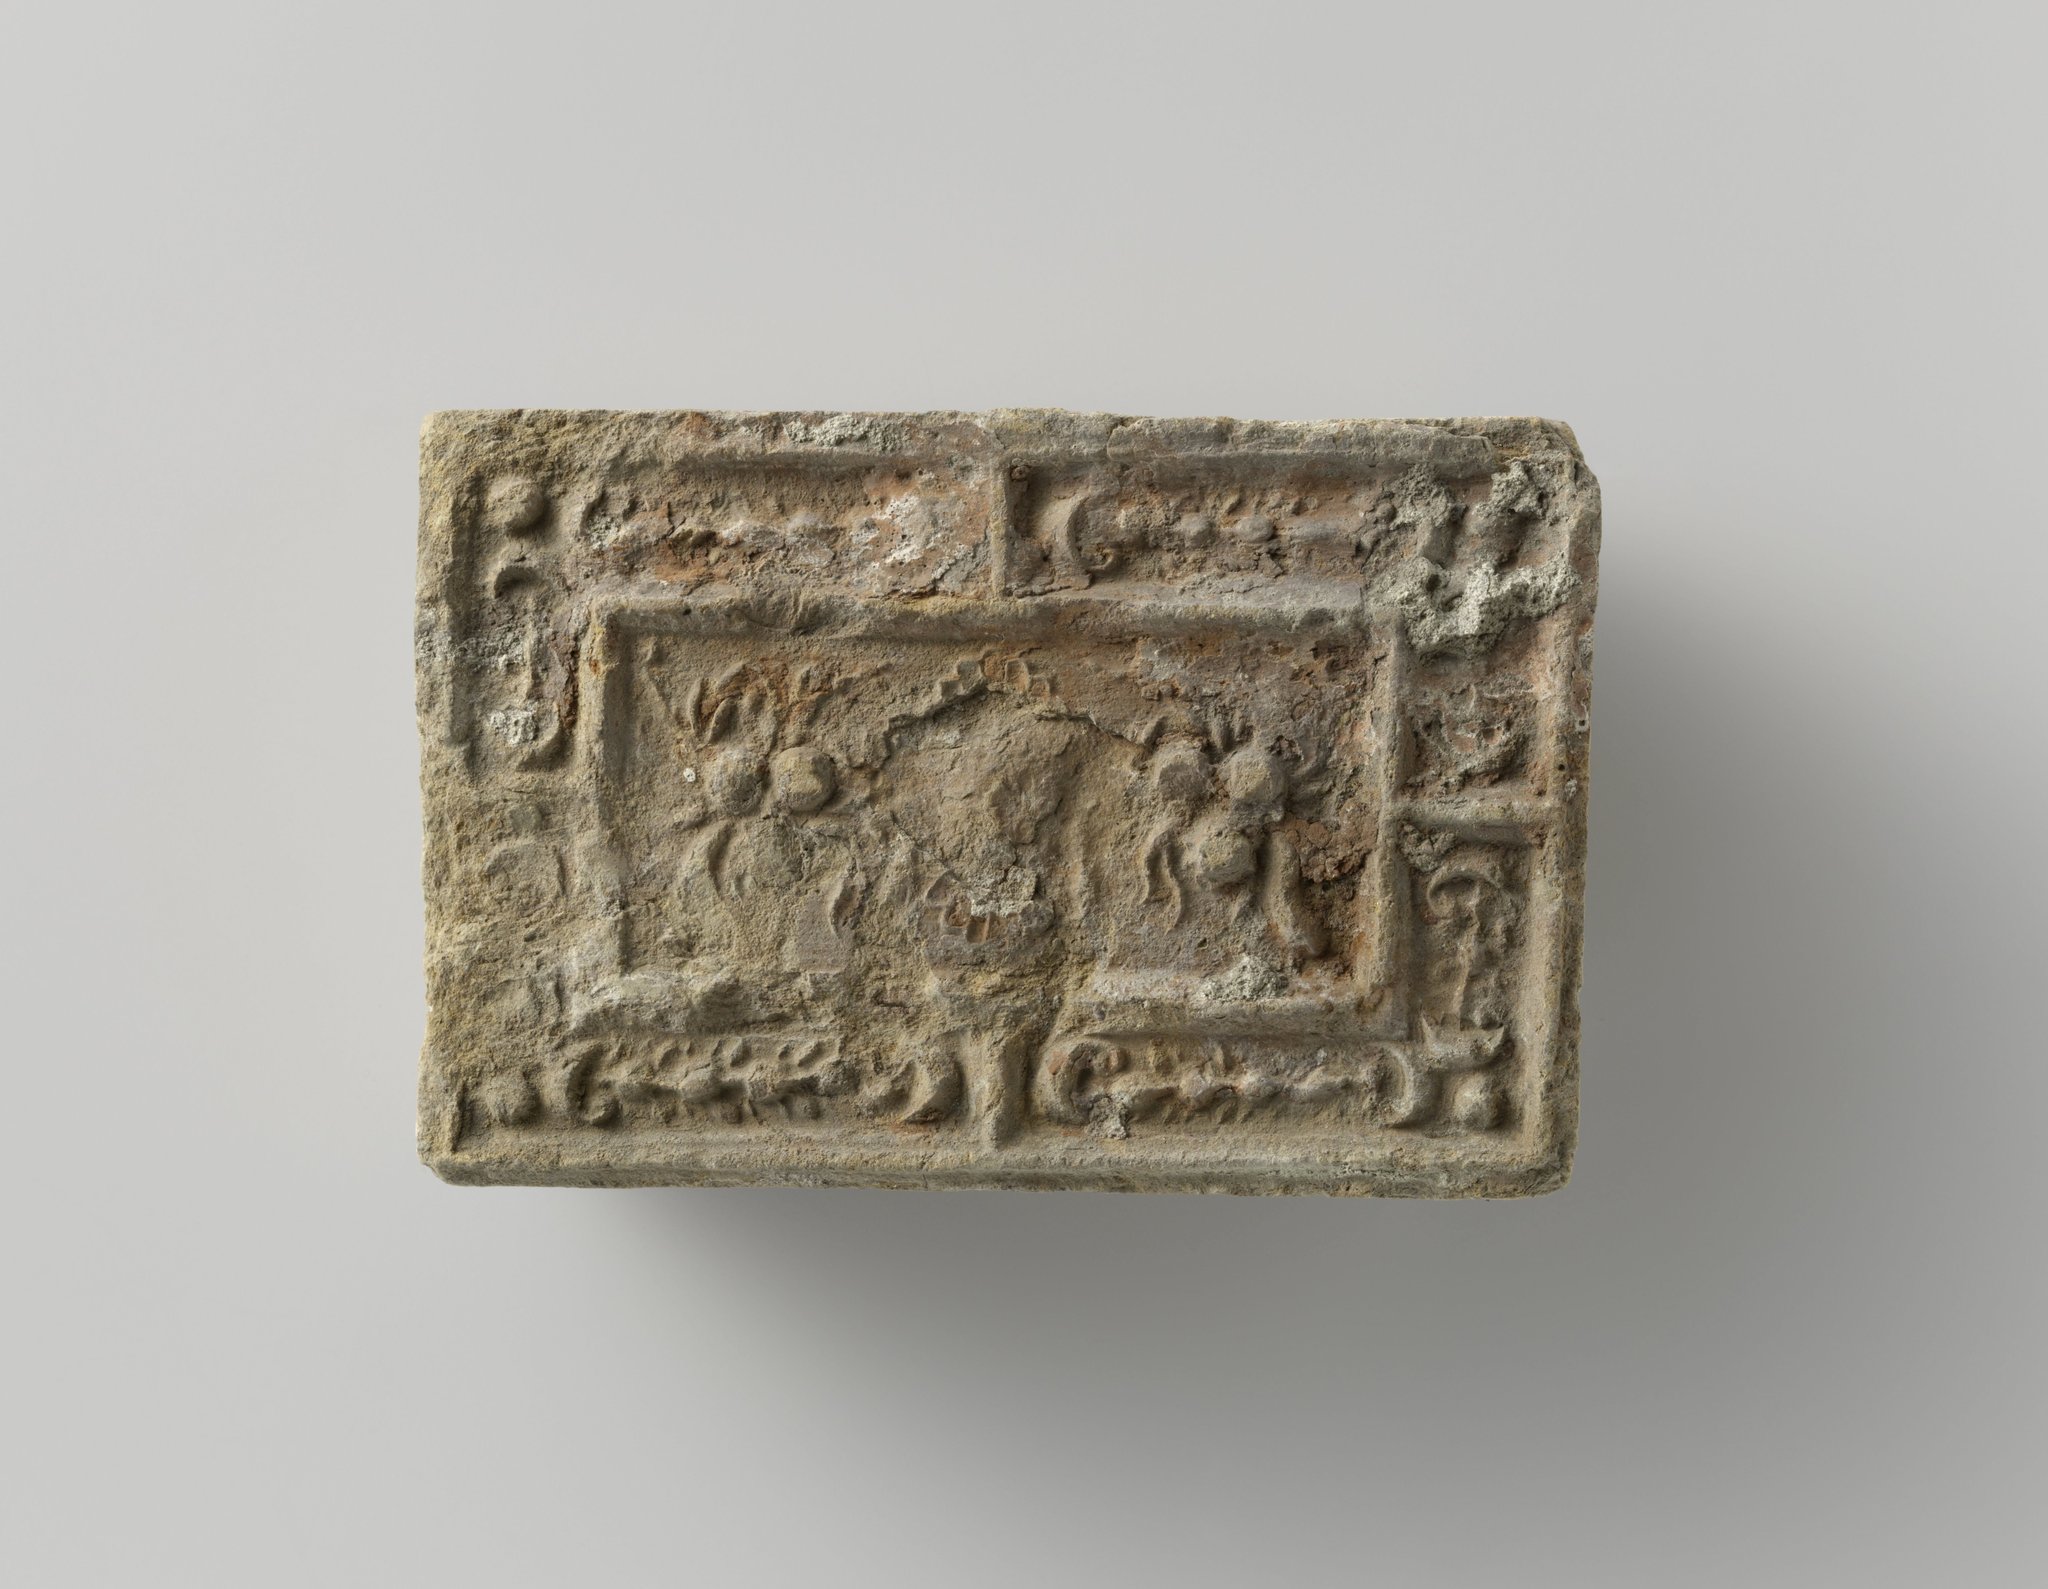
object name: hearthstone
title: Haardsteen met voorstelling van een mascaron tussen twee vruchtfestoenen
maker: Anonymous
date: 1575-1600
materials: earthenware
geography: antwerp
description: Haardsteen van gebakken aarde, met een langwerpig vierkante cartouche waarin een mascaron en guirlanden van vruchten en daaromheen een doorlopende guirlande.